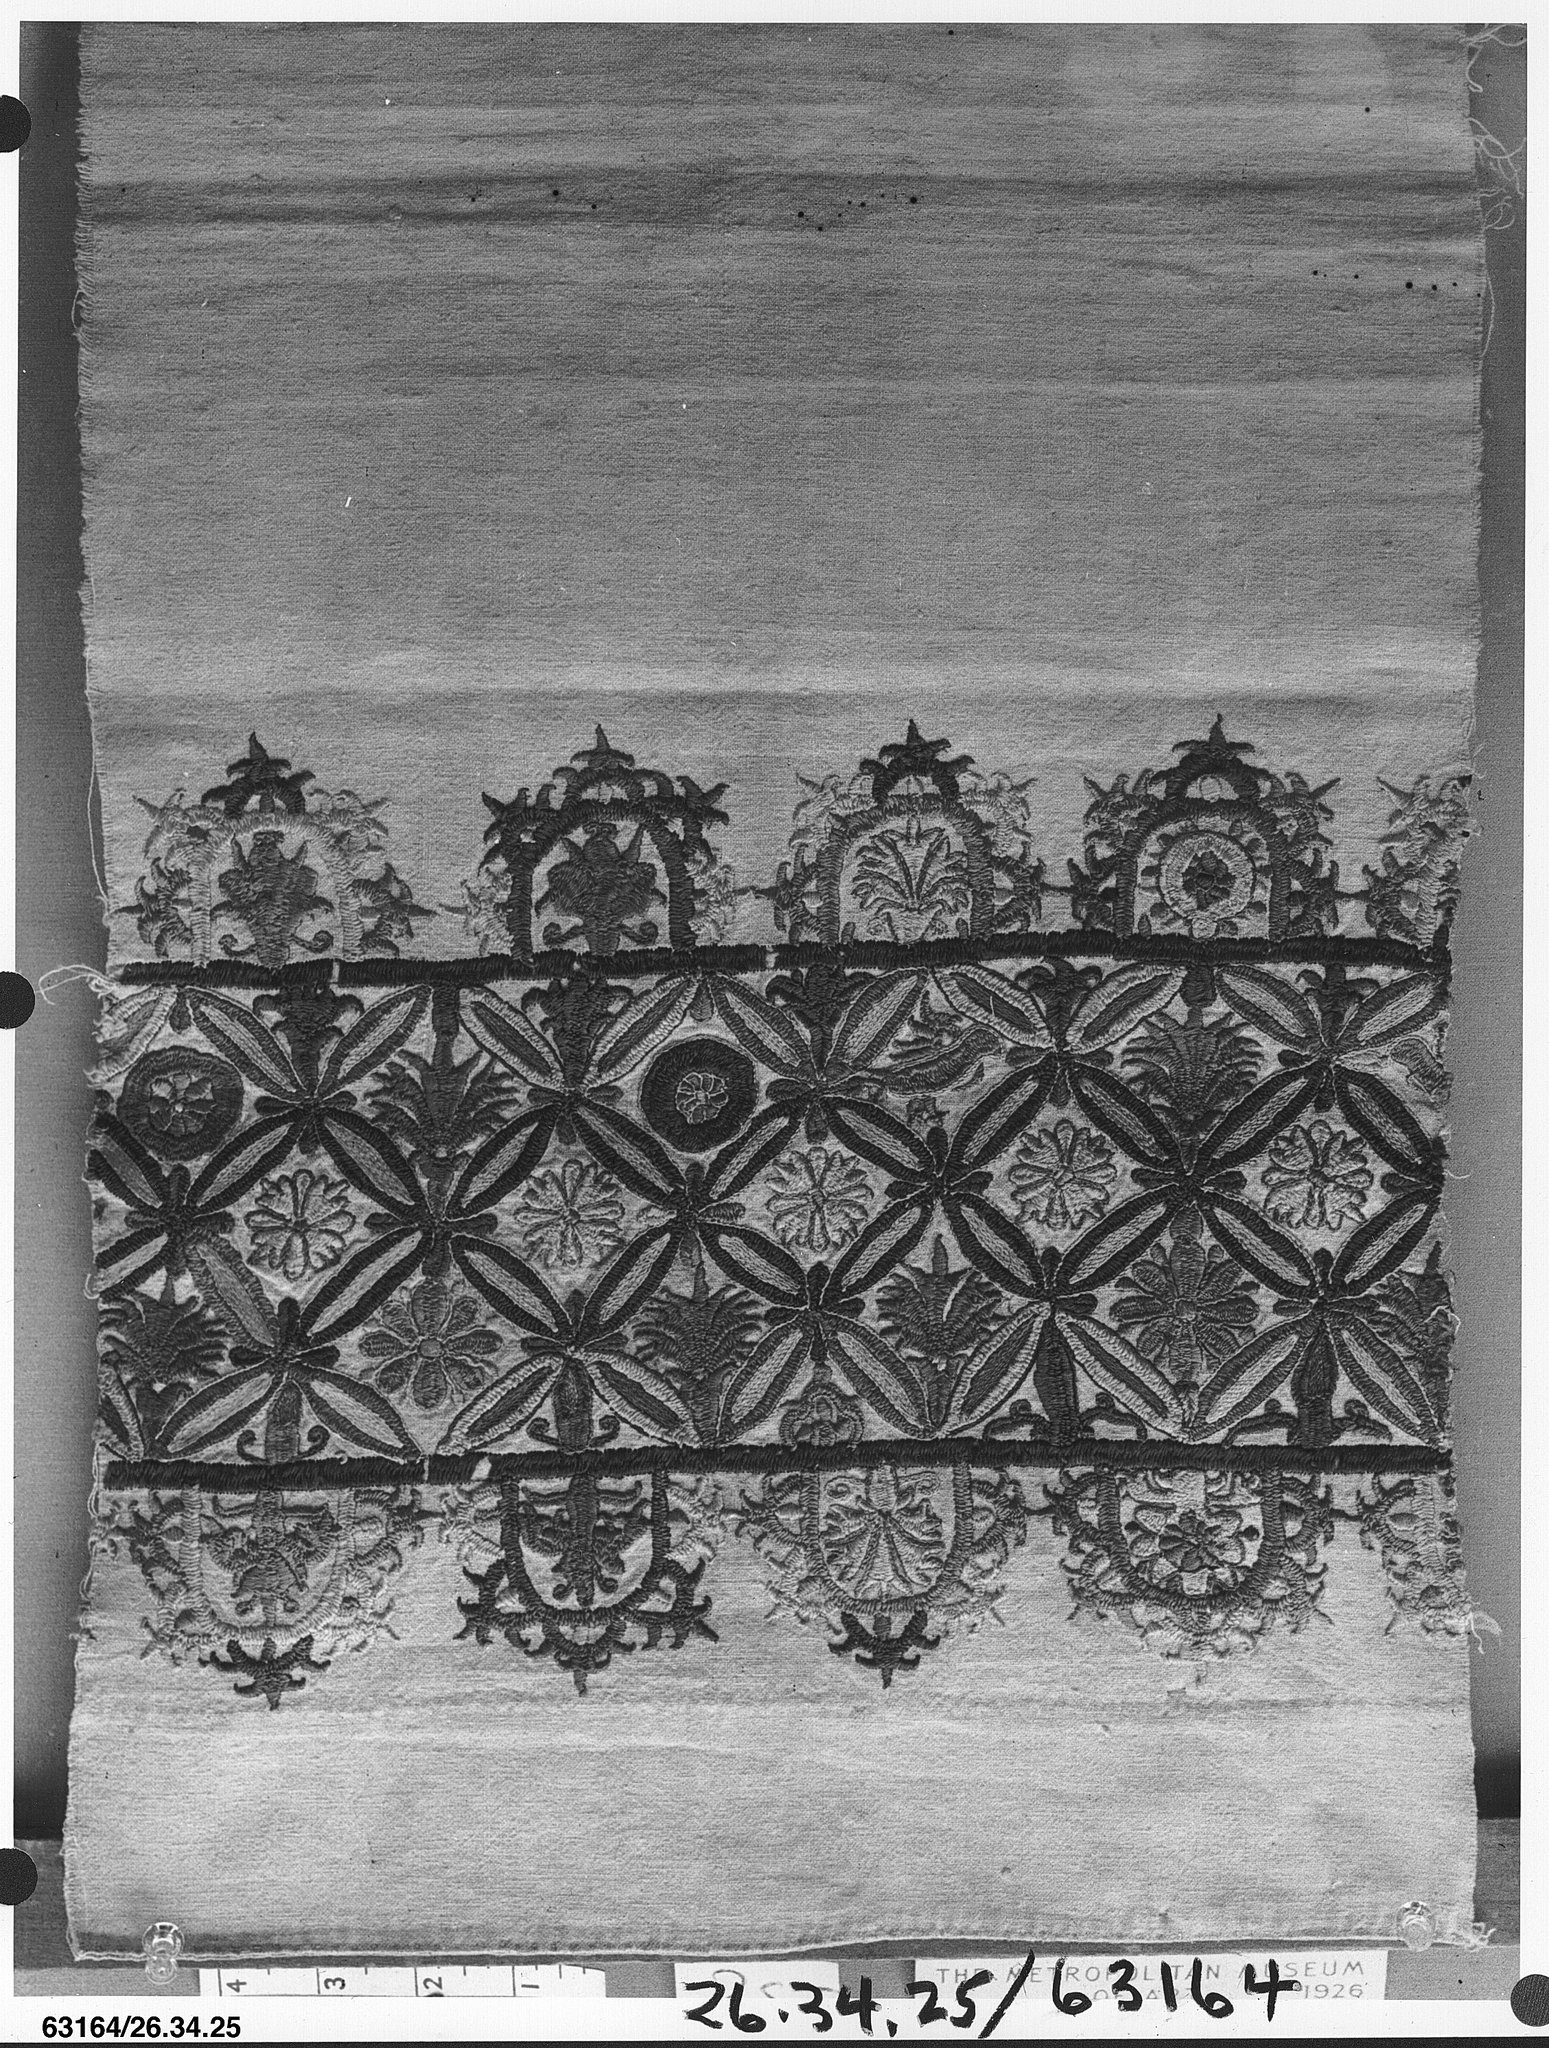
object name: border fragment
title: Part of a dress border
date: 1601-1800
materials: linen, silk